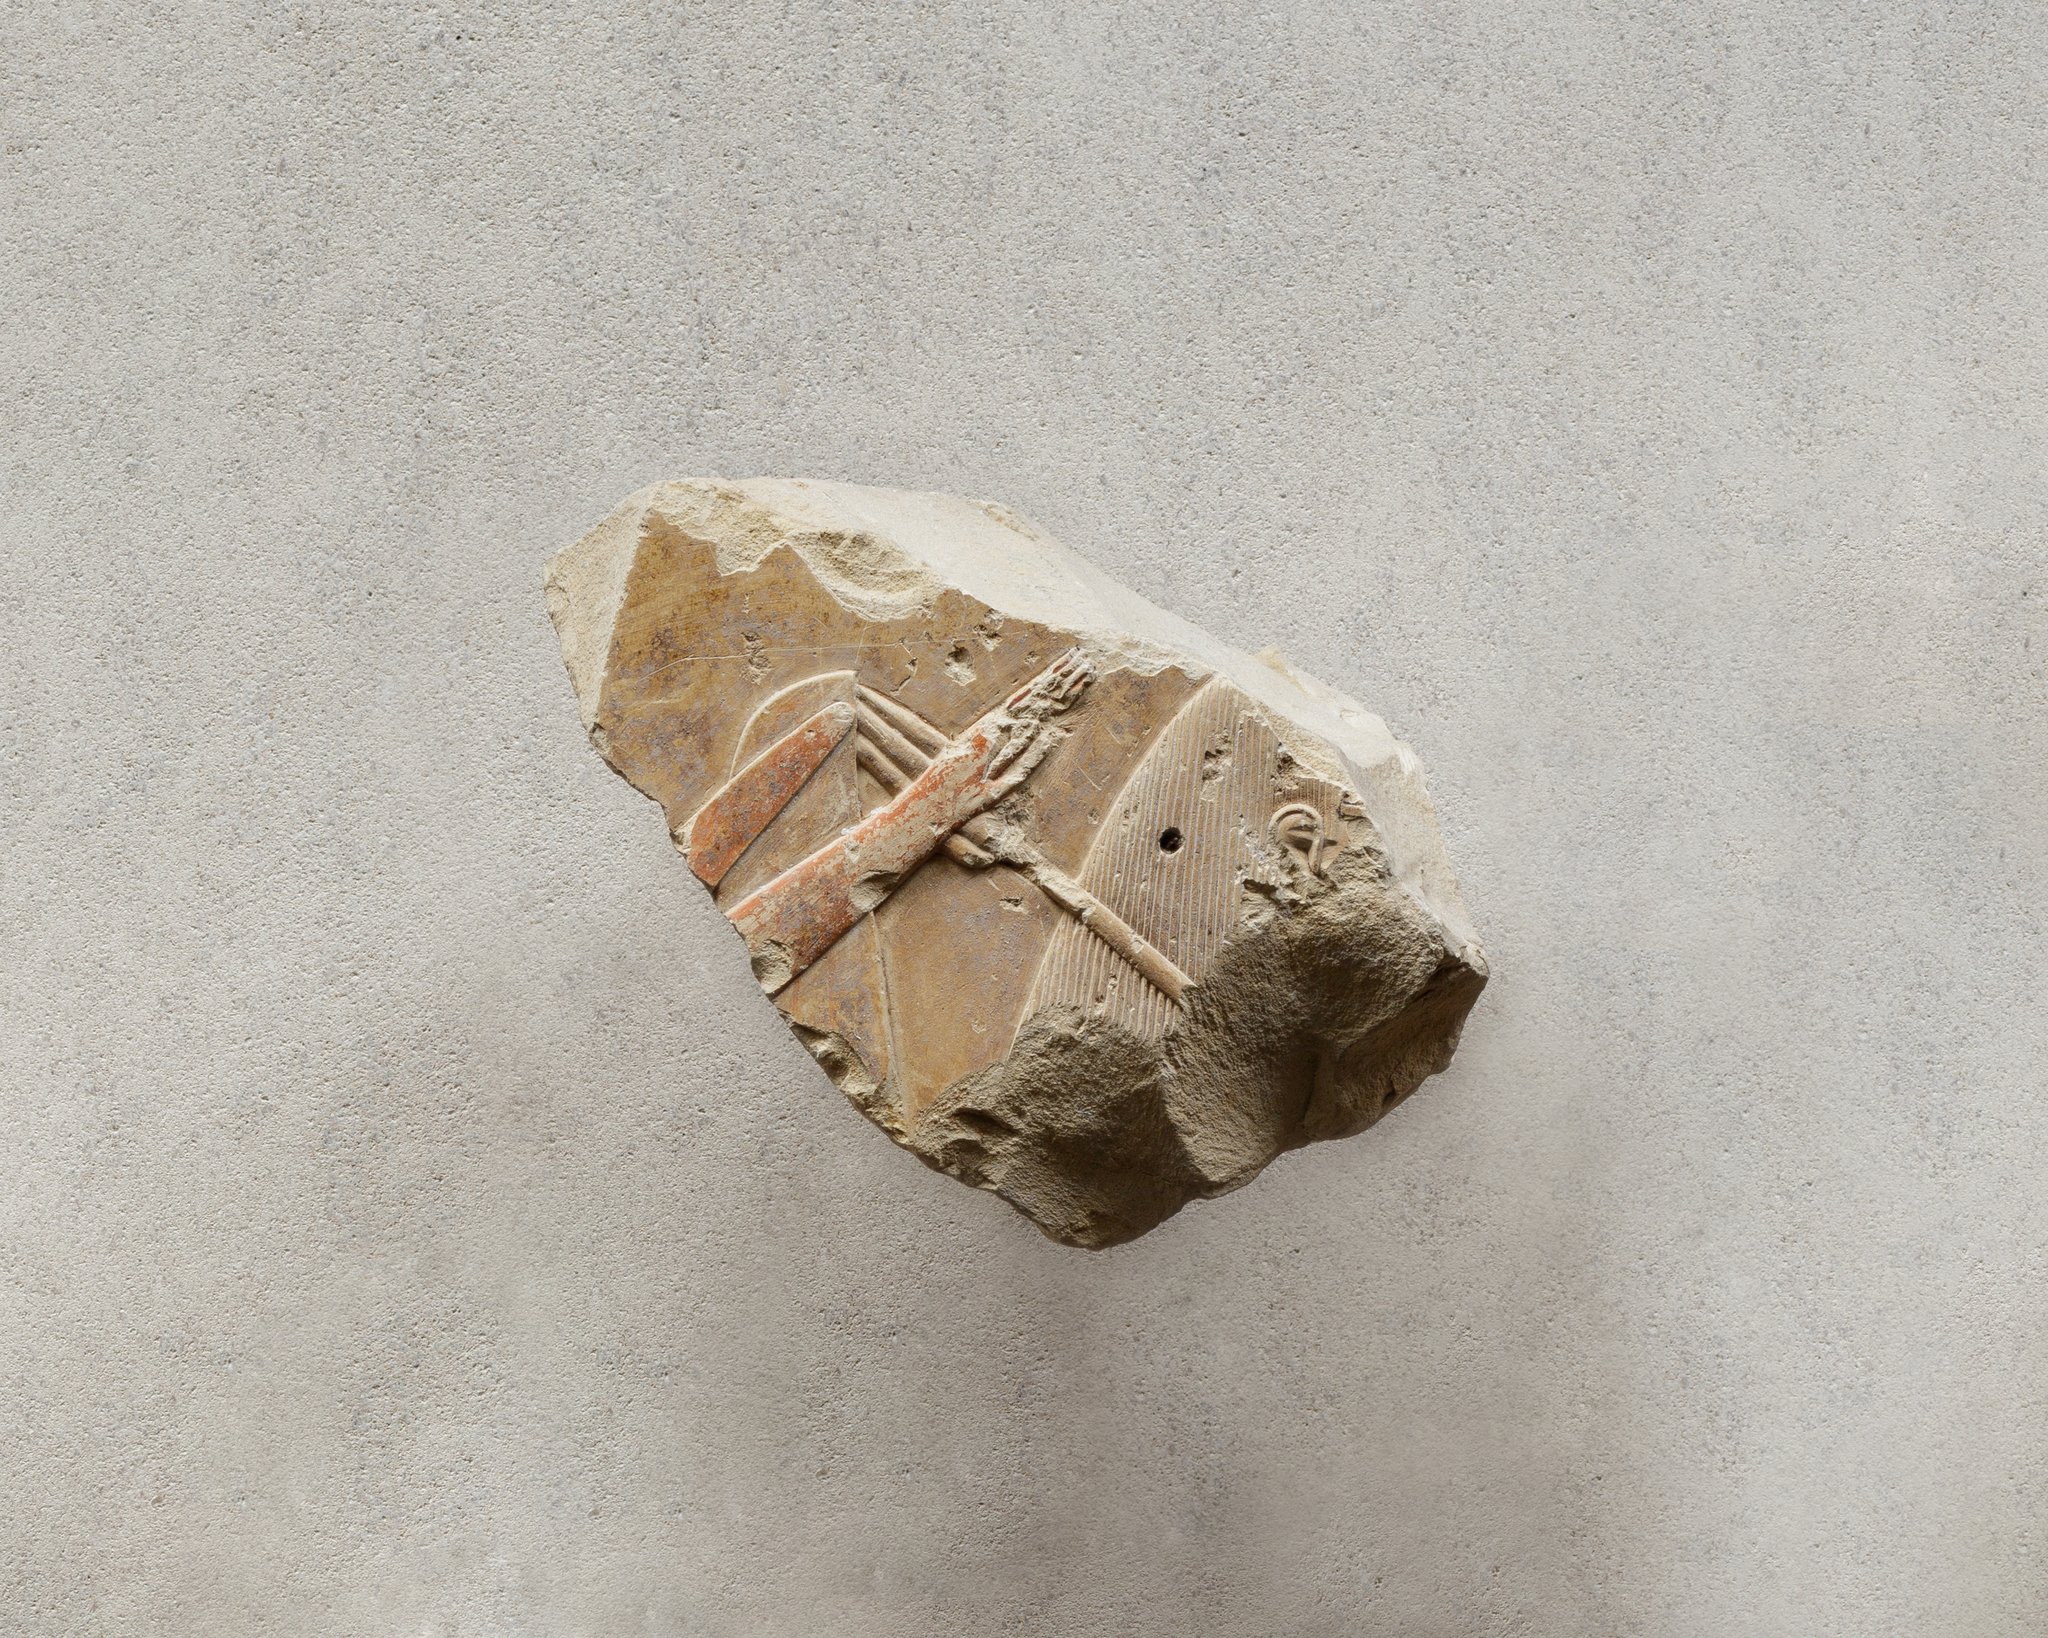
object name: relief, woman carrying sun shade, neferu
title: Relief from the tomb of Queen Neferu: female attendant carrying a sunshade (see 26.3.353-1)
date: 2051-2030 BCE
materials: limestone, paint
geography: egypt